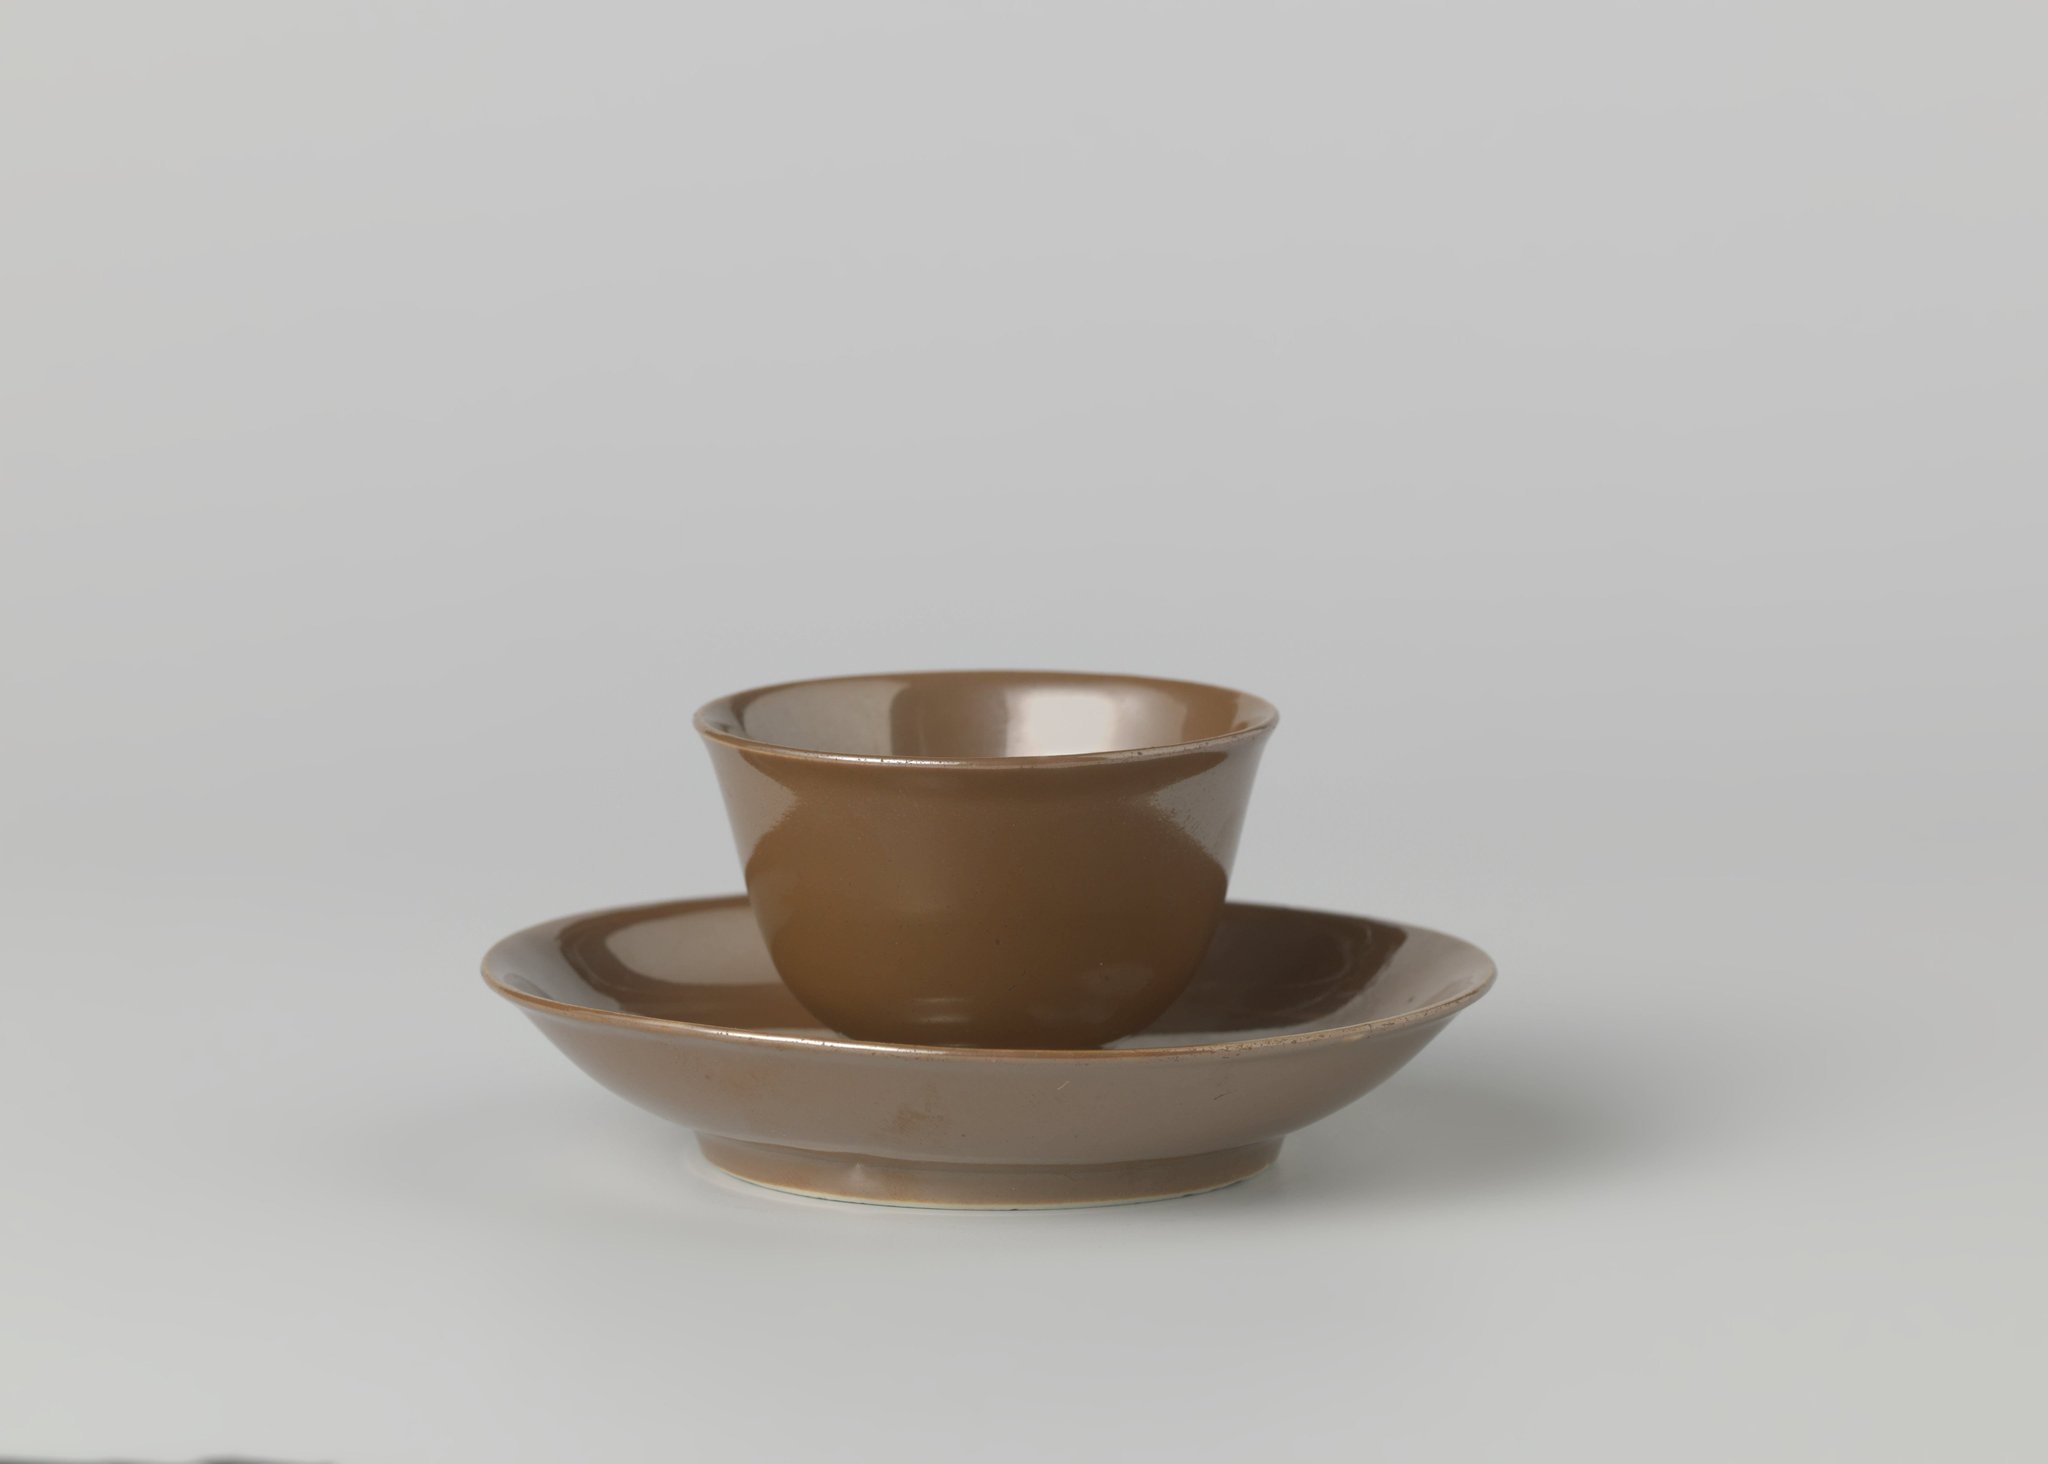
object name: cup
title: Cup and Saucer with a Dark Brown Glaze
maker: Anonymous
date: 1730-1770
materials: glaze, porcelain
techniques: firing, turning, vitrification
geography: china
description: This specific brown glaze is described as cafe-au-lait in Europe. High concentrations of iron oxide were used to colour the glaze a deep rich brown. Another name for it was ‘Batavia brown’, referring to the VOC trading postfrom where these products were trans-shipped to Europe.